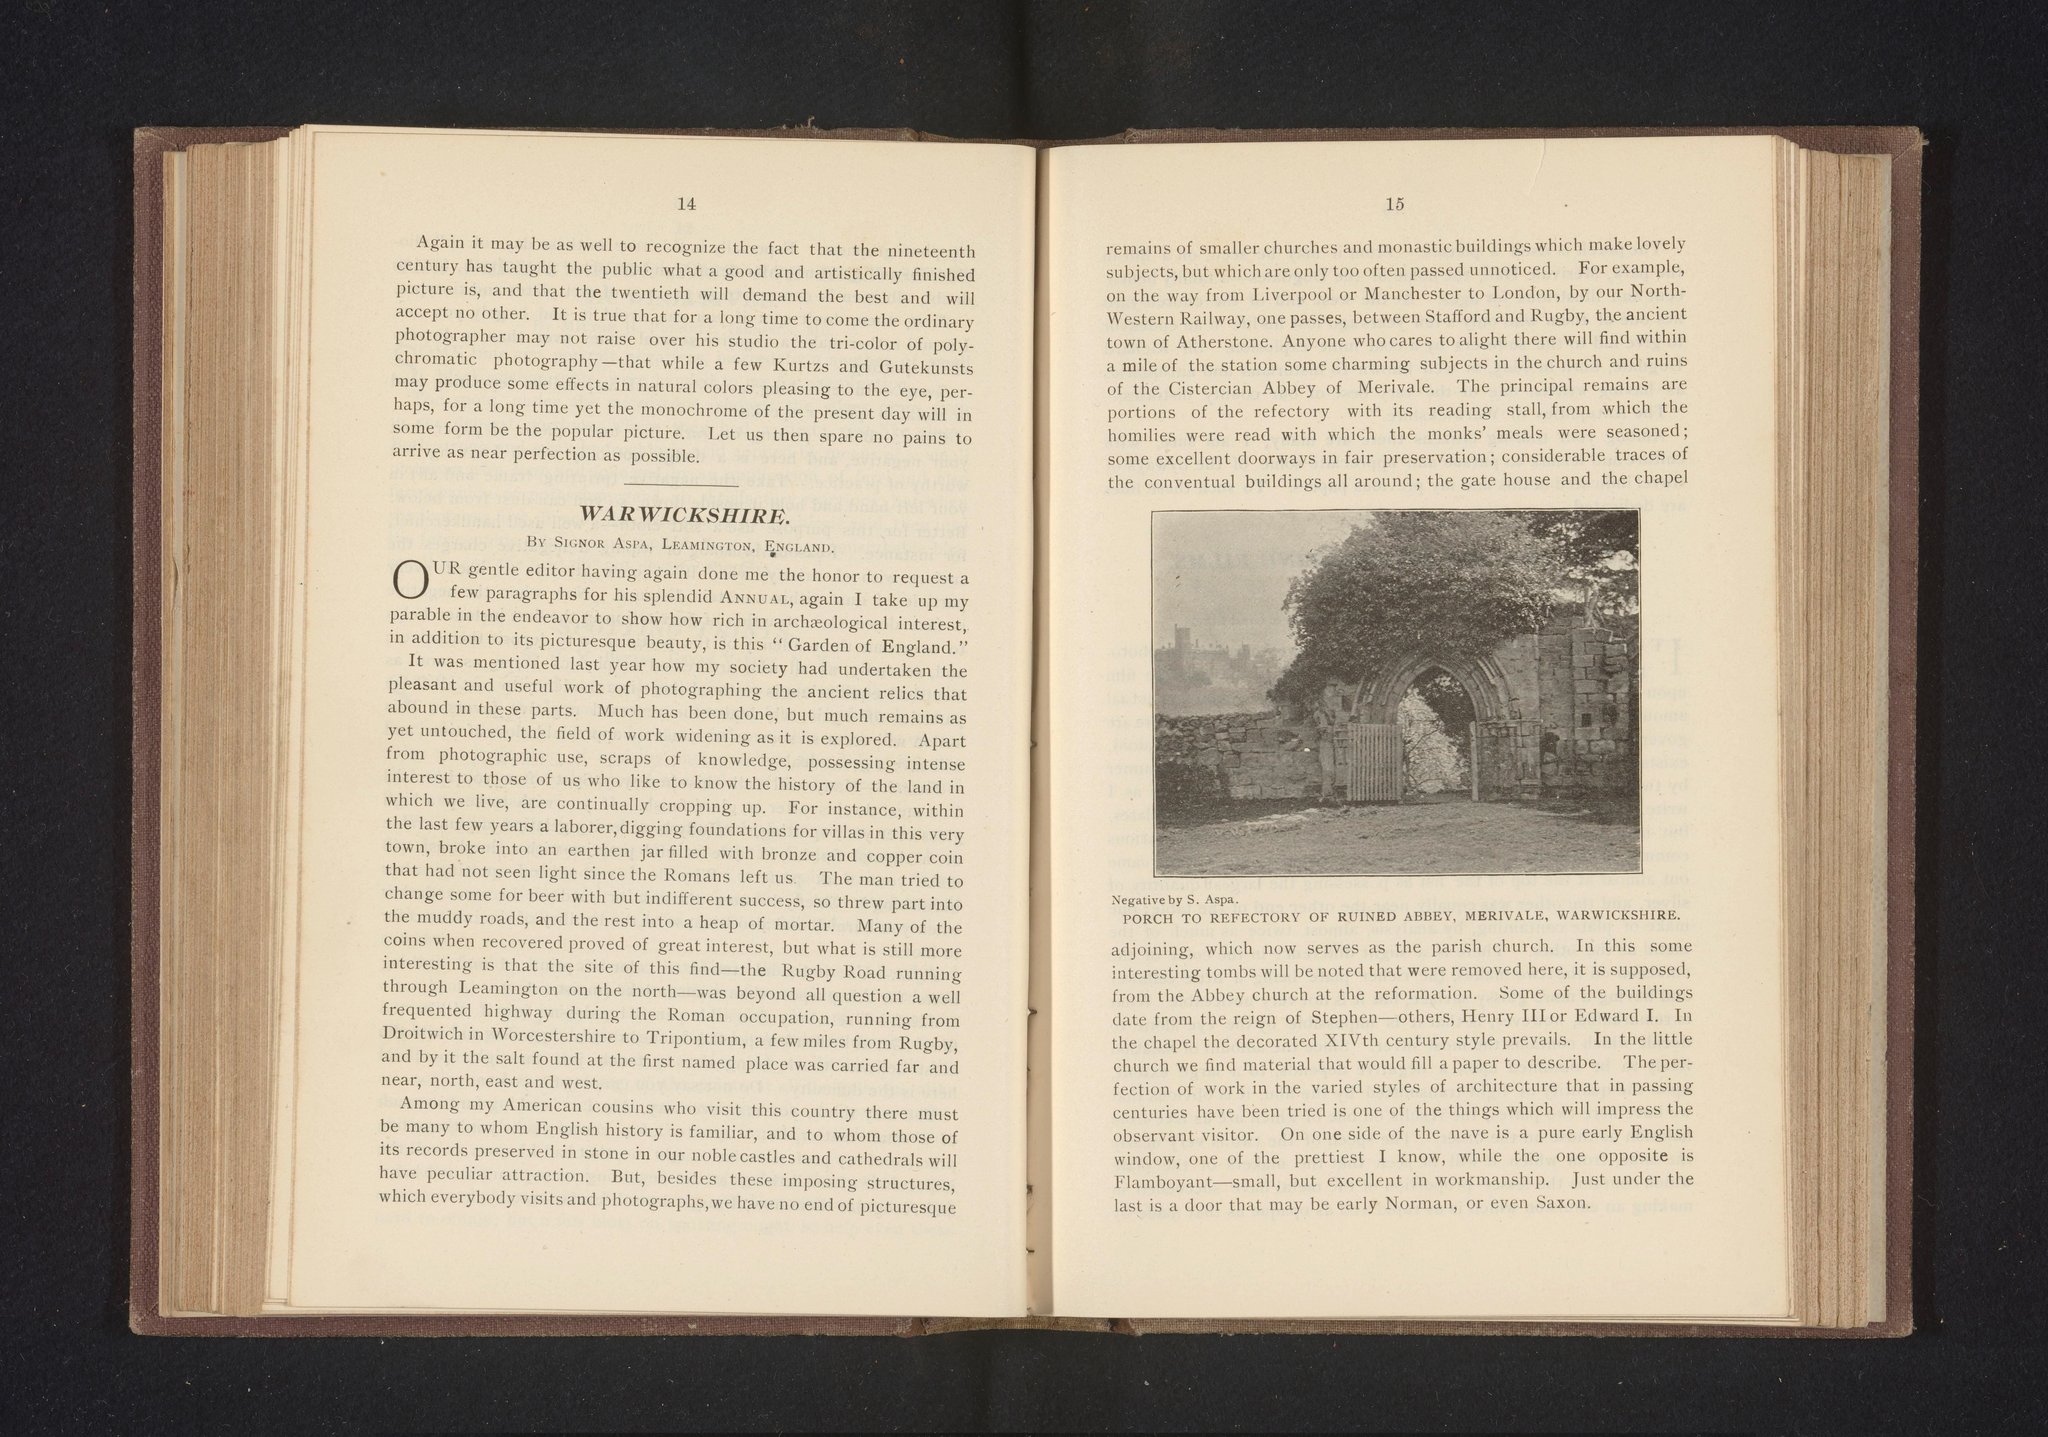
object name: page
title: Porch to refectory of ruined abbey, Merivale, Warwickshire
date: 1890-1895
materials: paper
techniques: autotype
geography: merevale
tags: ruin of church, monastery, etc.